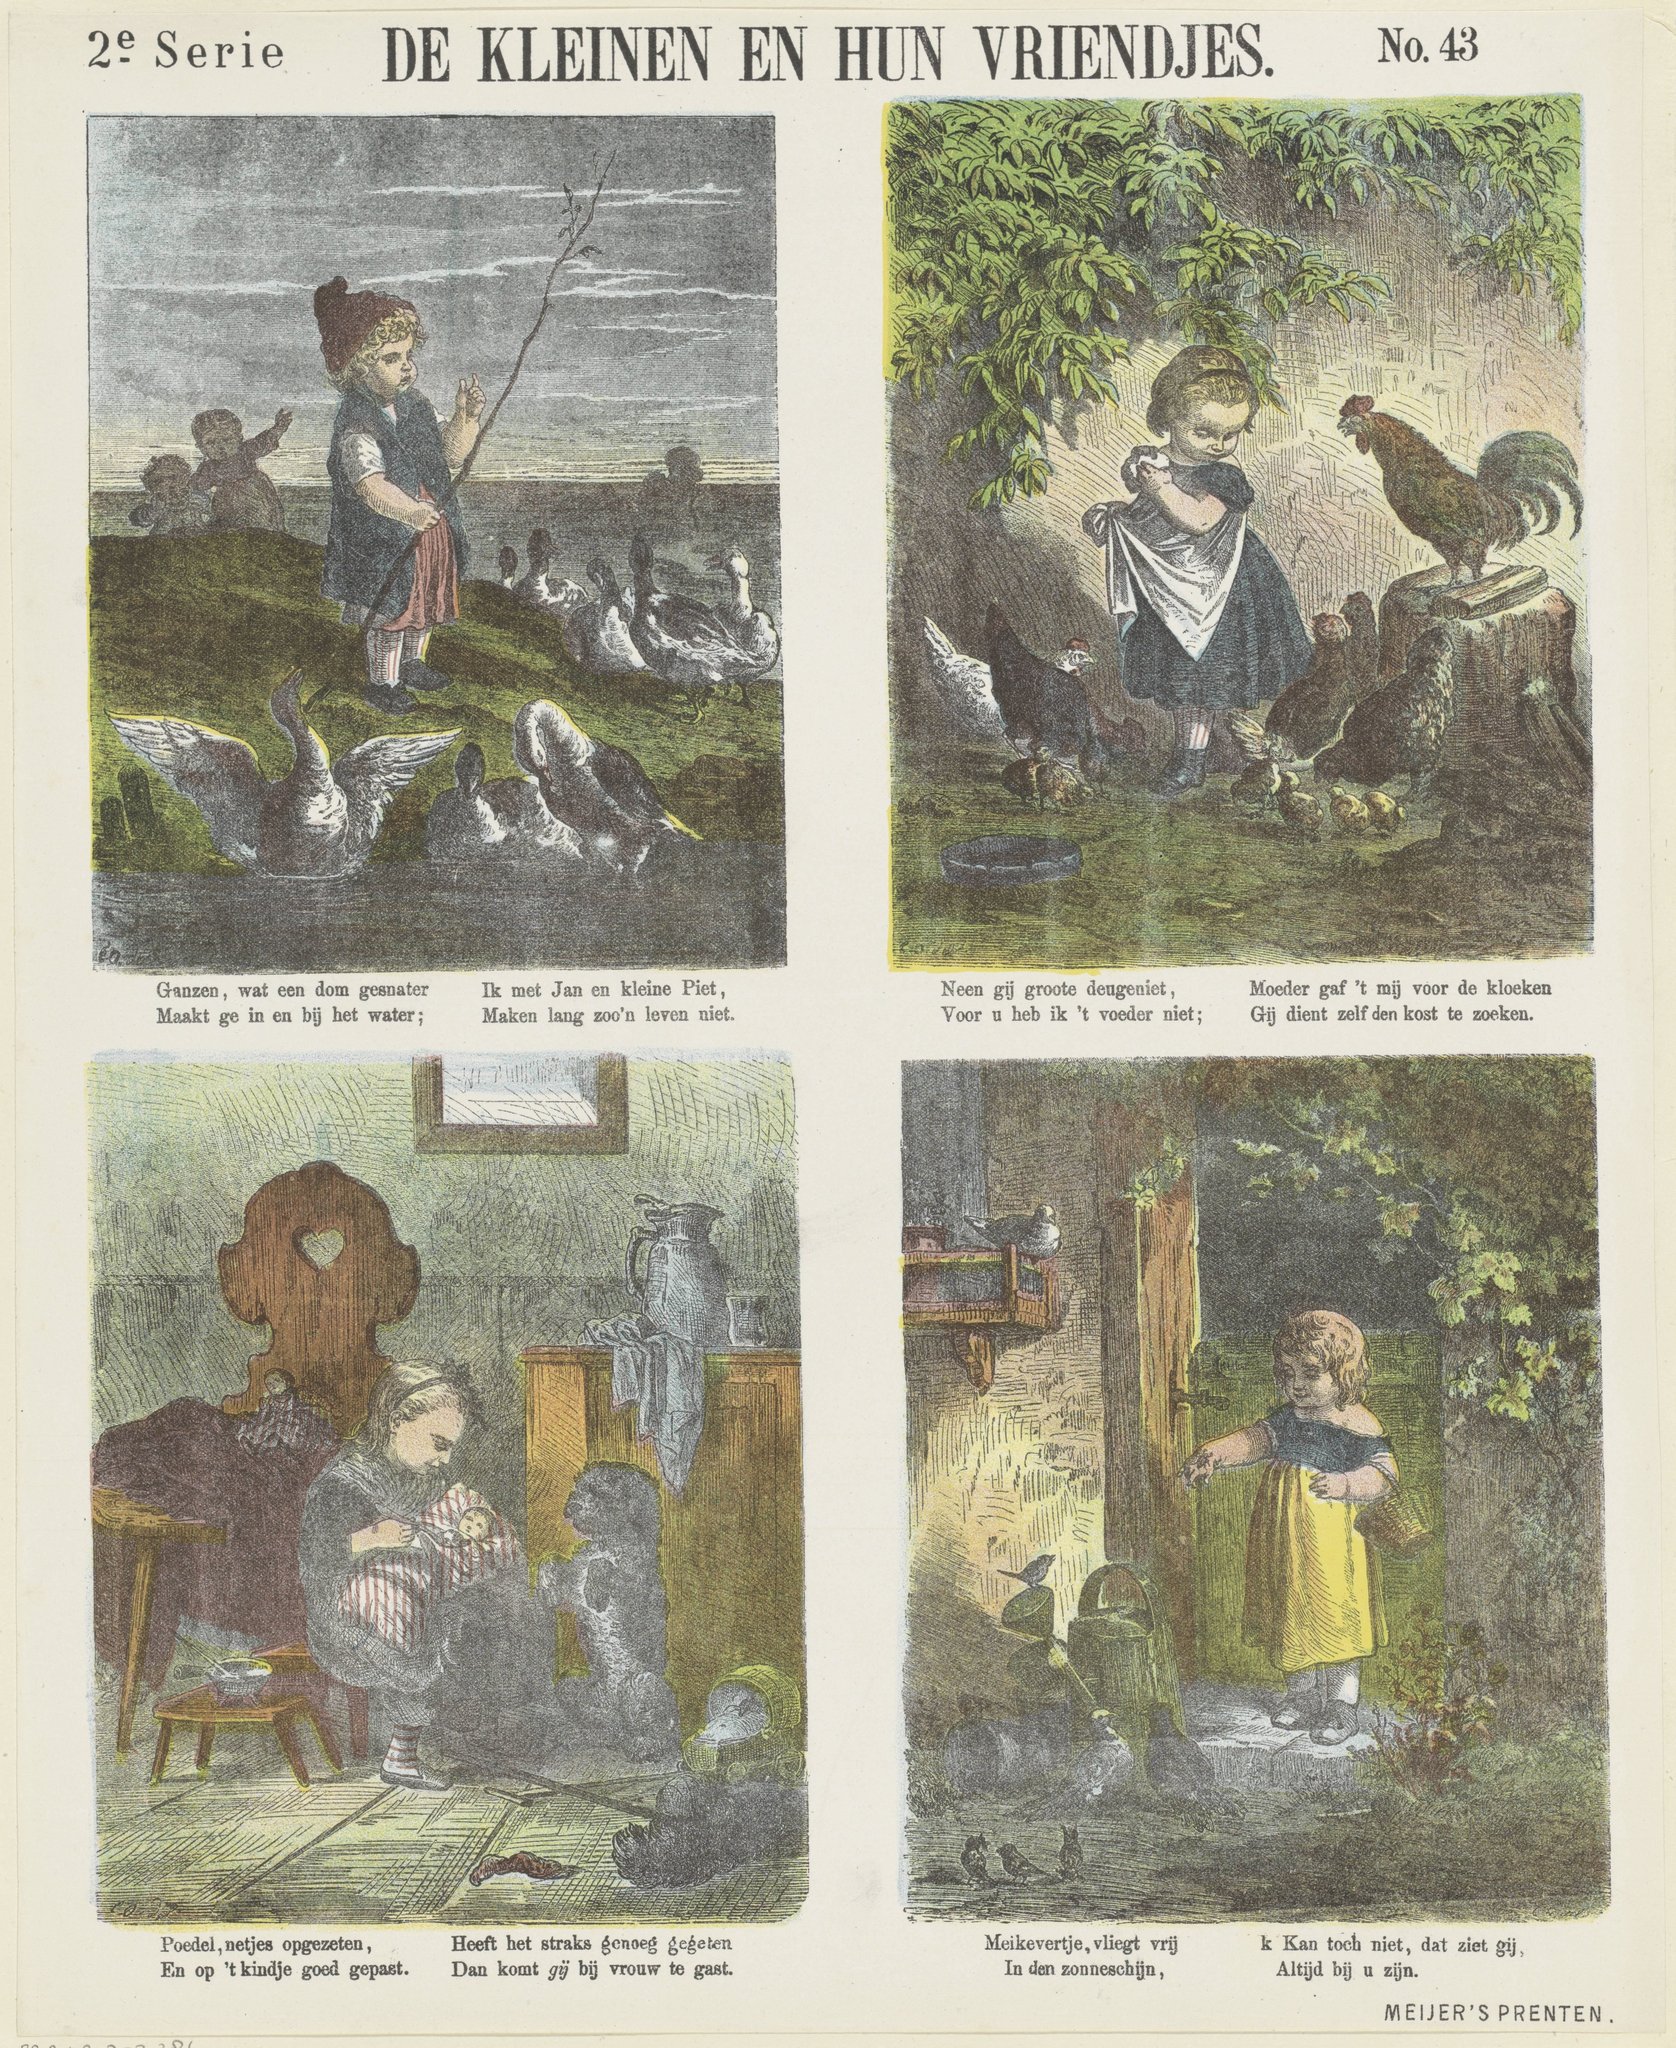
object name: print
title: De kleinen en hun vriendjes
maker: Anonymous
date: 1874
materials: paper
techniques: lithograph, letterpress printing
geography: amsterdam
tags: animals, child, child playing with animals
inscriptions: collector's mark: Lugt 2760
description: Blad met 4 voorstellingen van kinderen die met dieren spelen. Onder elke afbeelding een vierregelig vers in twee kolommen. Genummerd rechtsboven: No. 43.